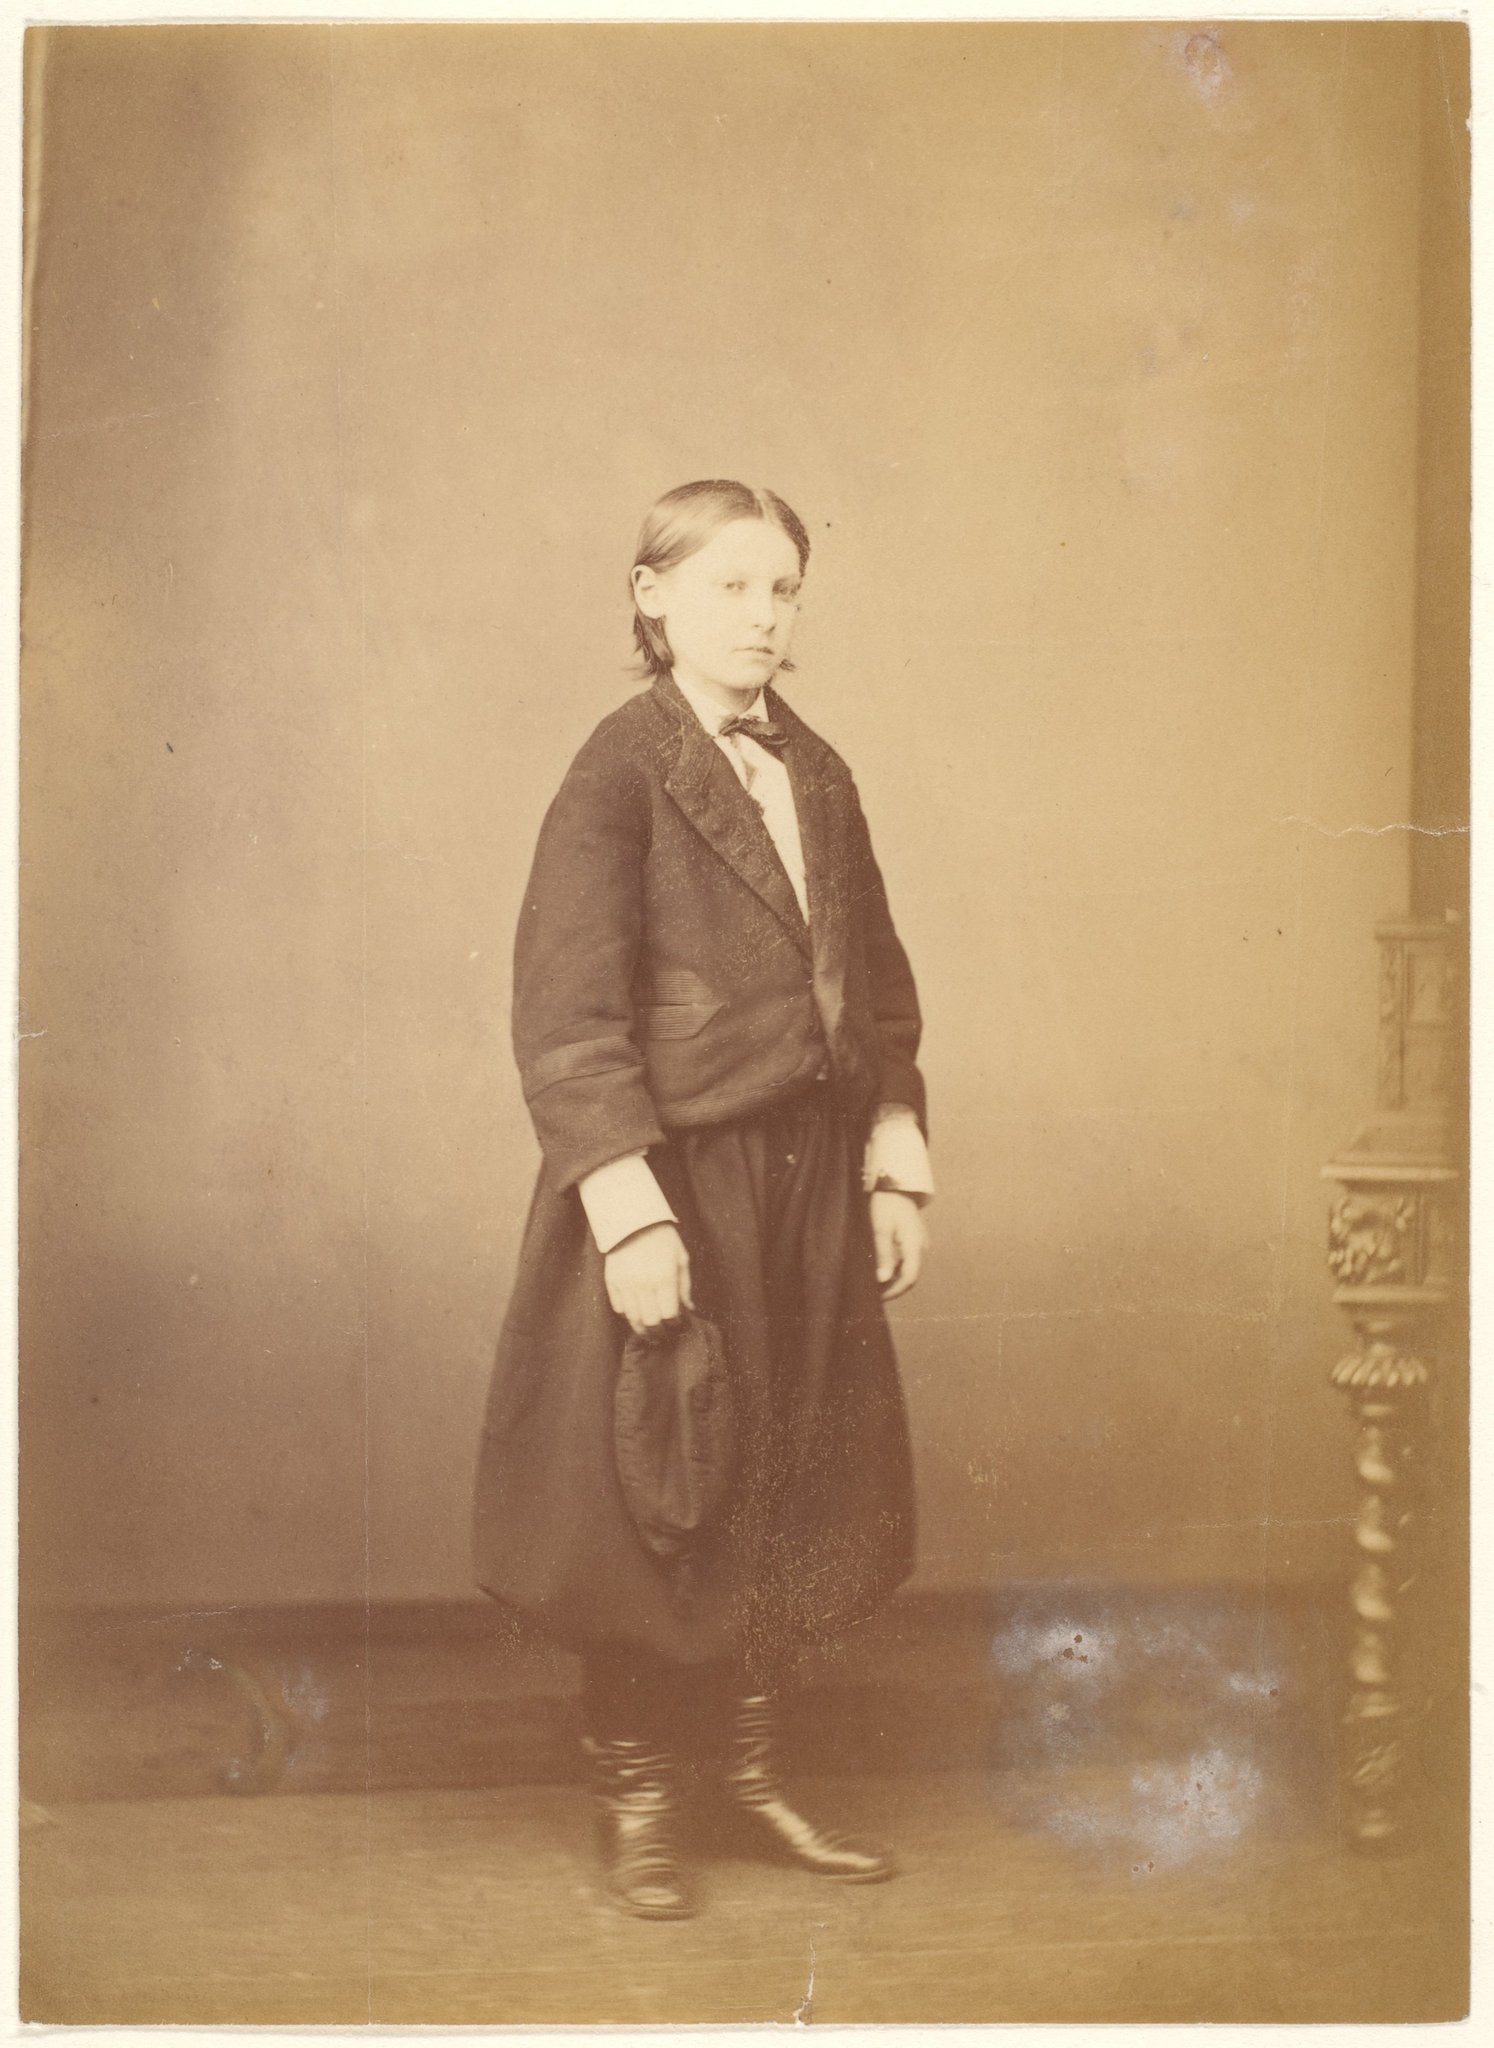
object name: photograph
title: Le Grand Russe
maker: pierre-louis pierson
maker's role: artist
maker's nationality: french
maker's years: 1822-1913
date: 1860-1869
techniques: albumen silver print, glass negative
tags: boys,portraits